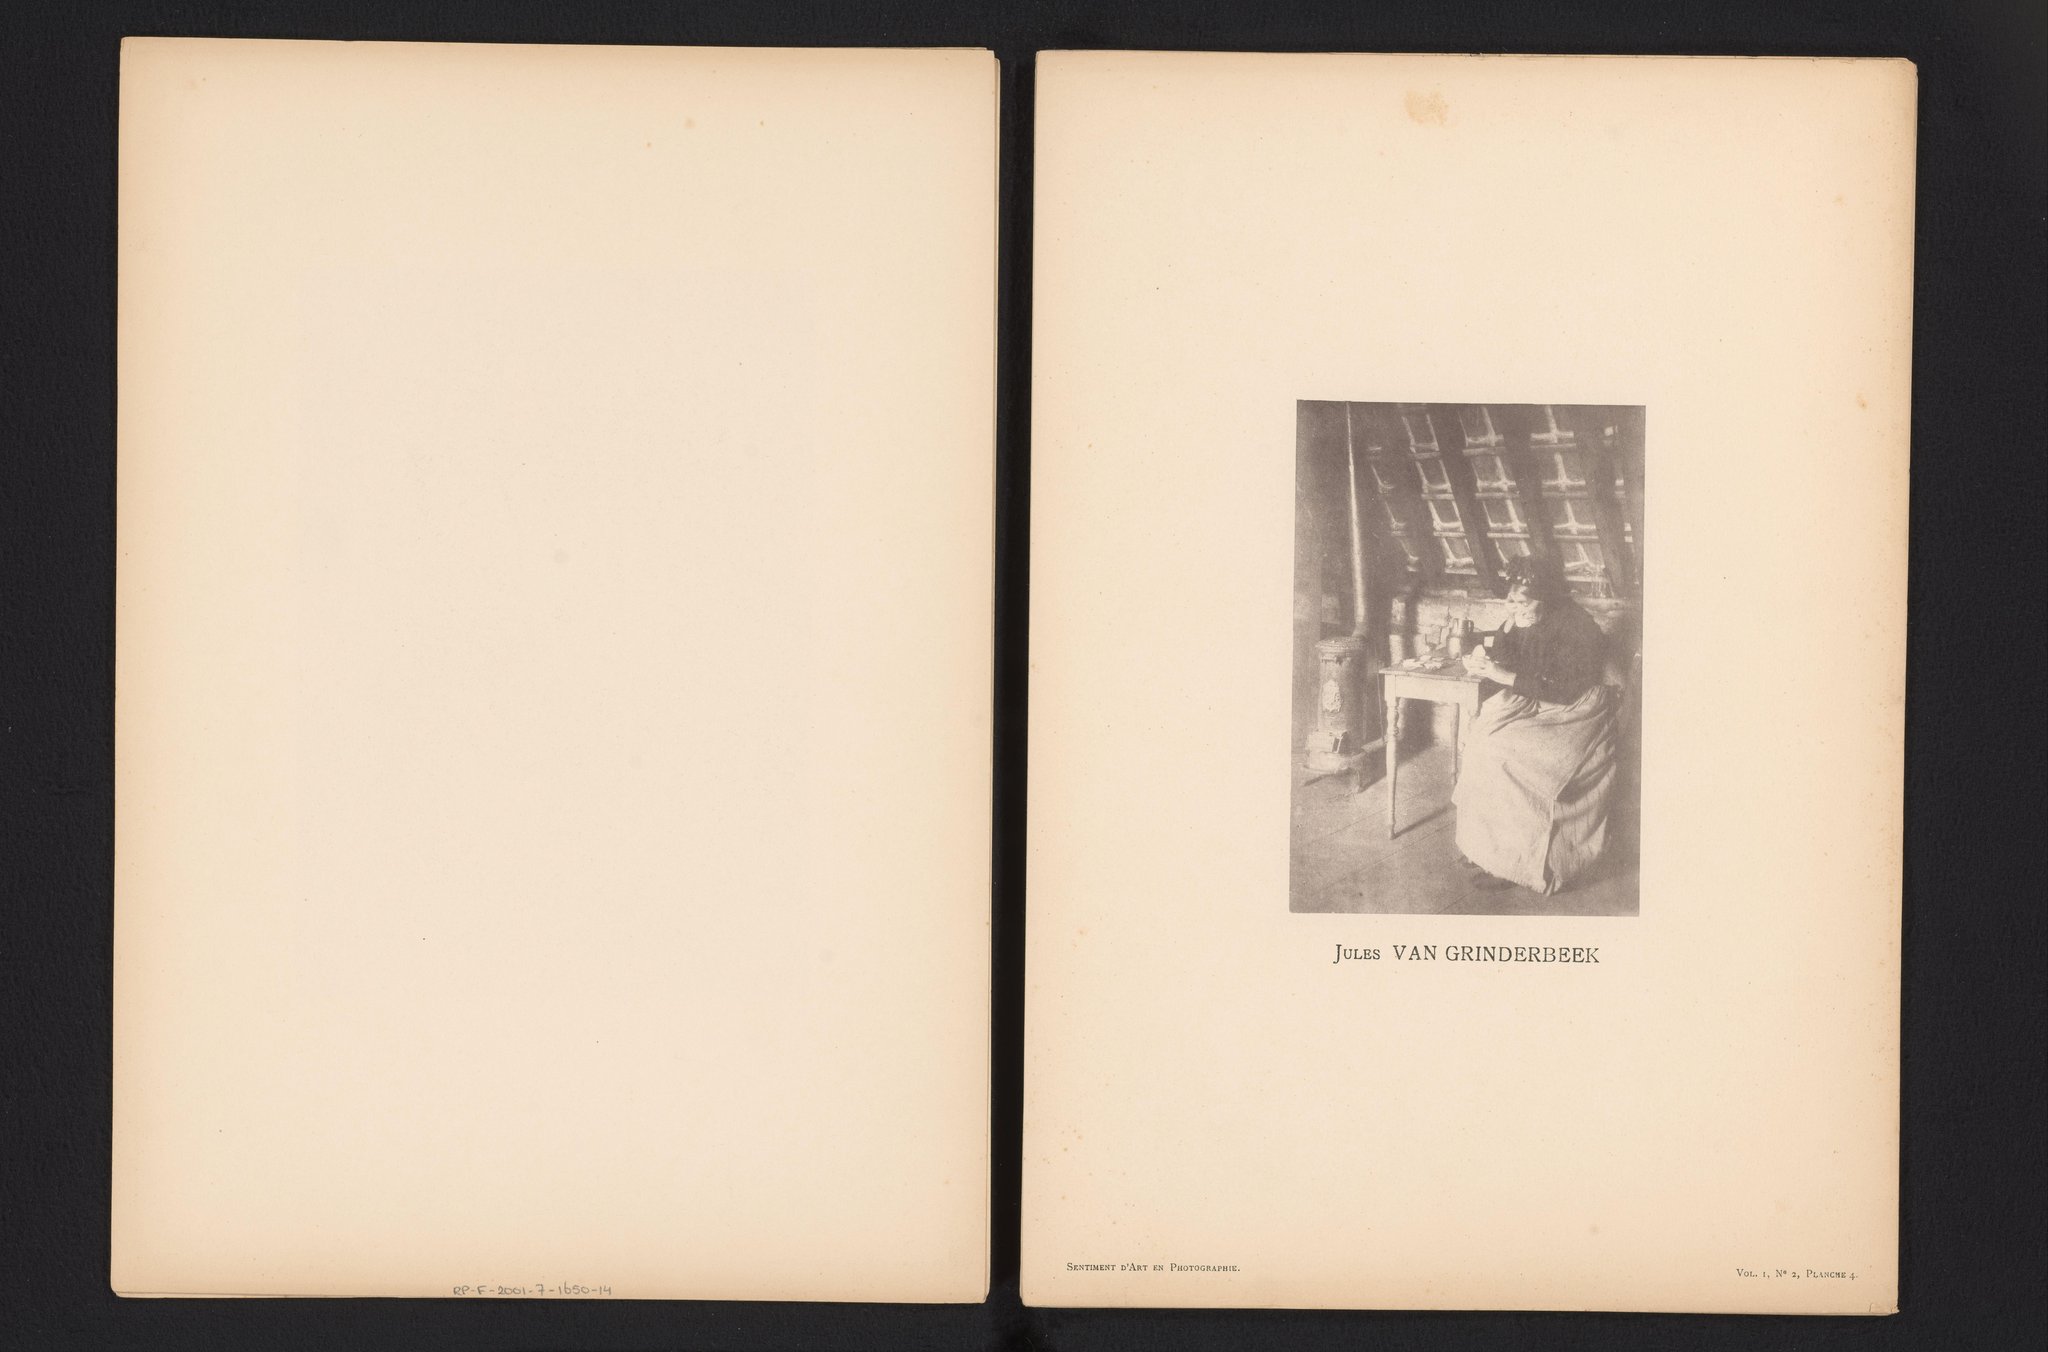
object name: photomechanical print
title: Sentiment d'Art en Photographie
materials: paper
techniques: photograph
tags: adult woman, table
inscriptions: number: ‘Vol. 1, No 2, Planche 4.’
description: Deze prent maakt deel uit van 8 omslagen met 22 tekstbladen en 89 prenten op losse bladen in en tussen de omslagen.